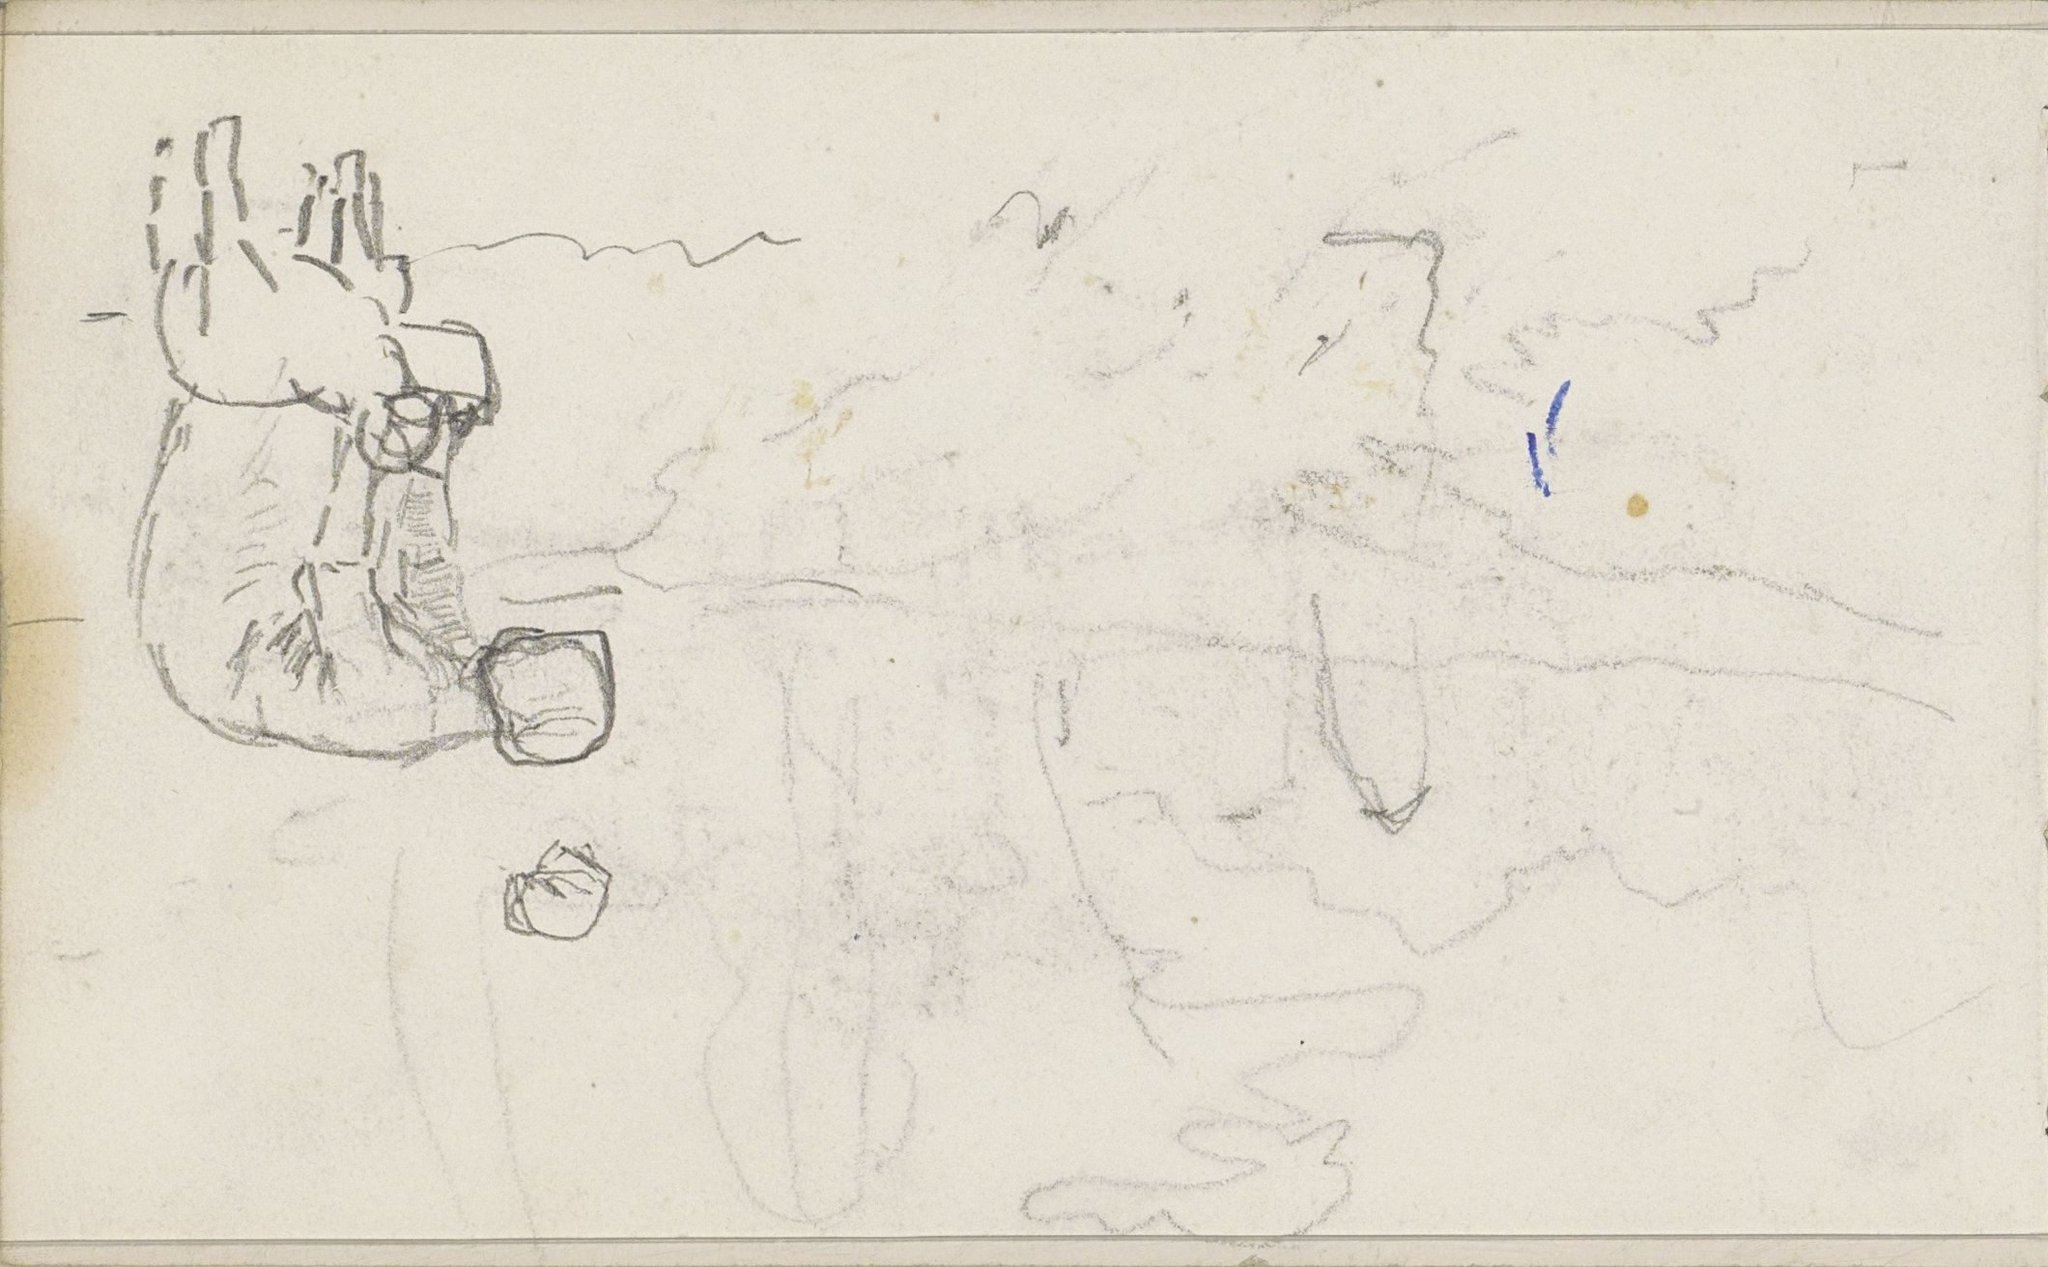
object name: sketchbook leaf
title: Boerin met een lam in een weiland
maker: anton mauve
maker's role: draughtsman, painter, print maker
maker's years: 1838-1888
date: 1848-1888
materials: paper, pencil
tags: farmers - aa - female farmer, farmer's wife, lamb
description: Blad 39 verso uit een schetsboek met 43 bladen.